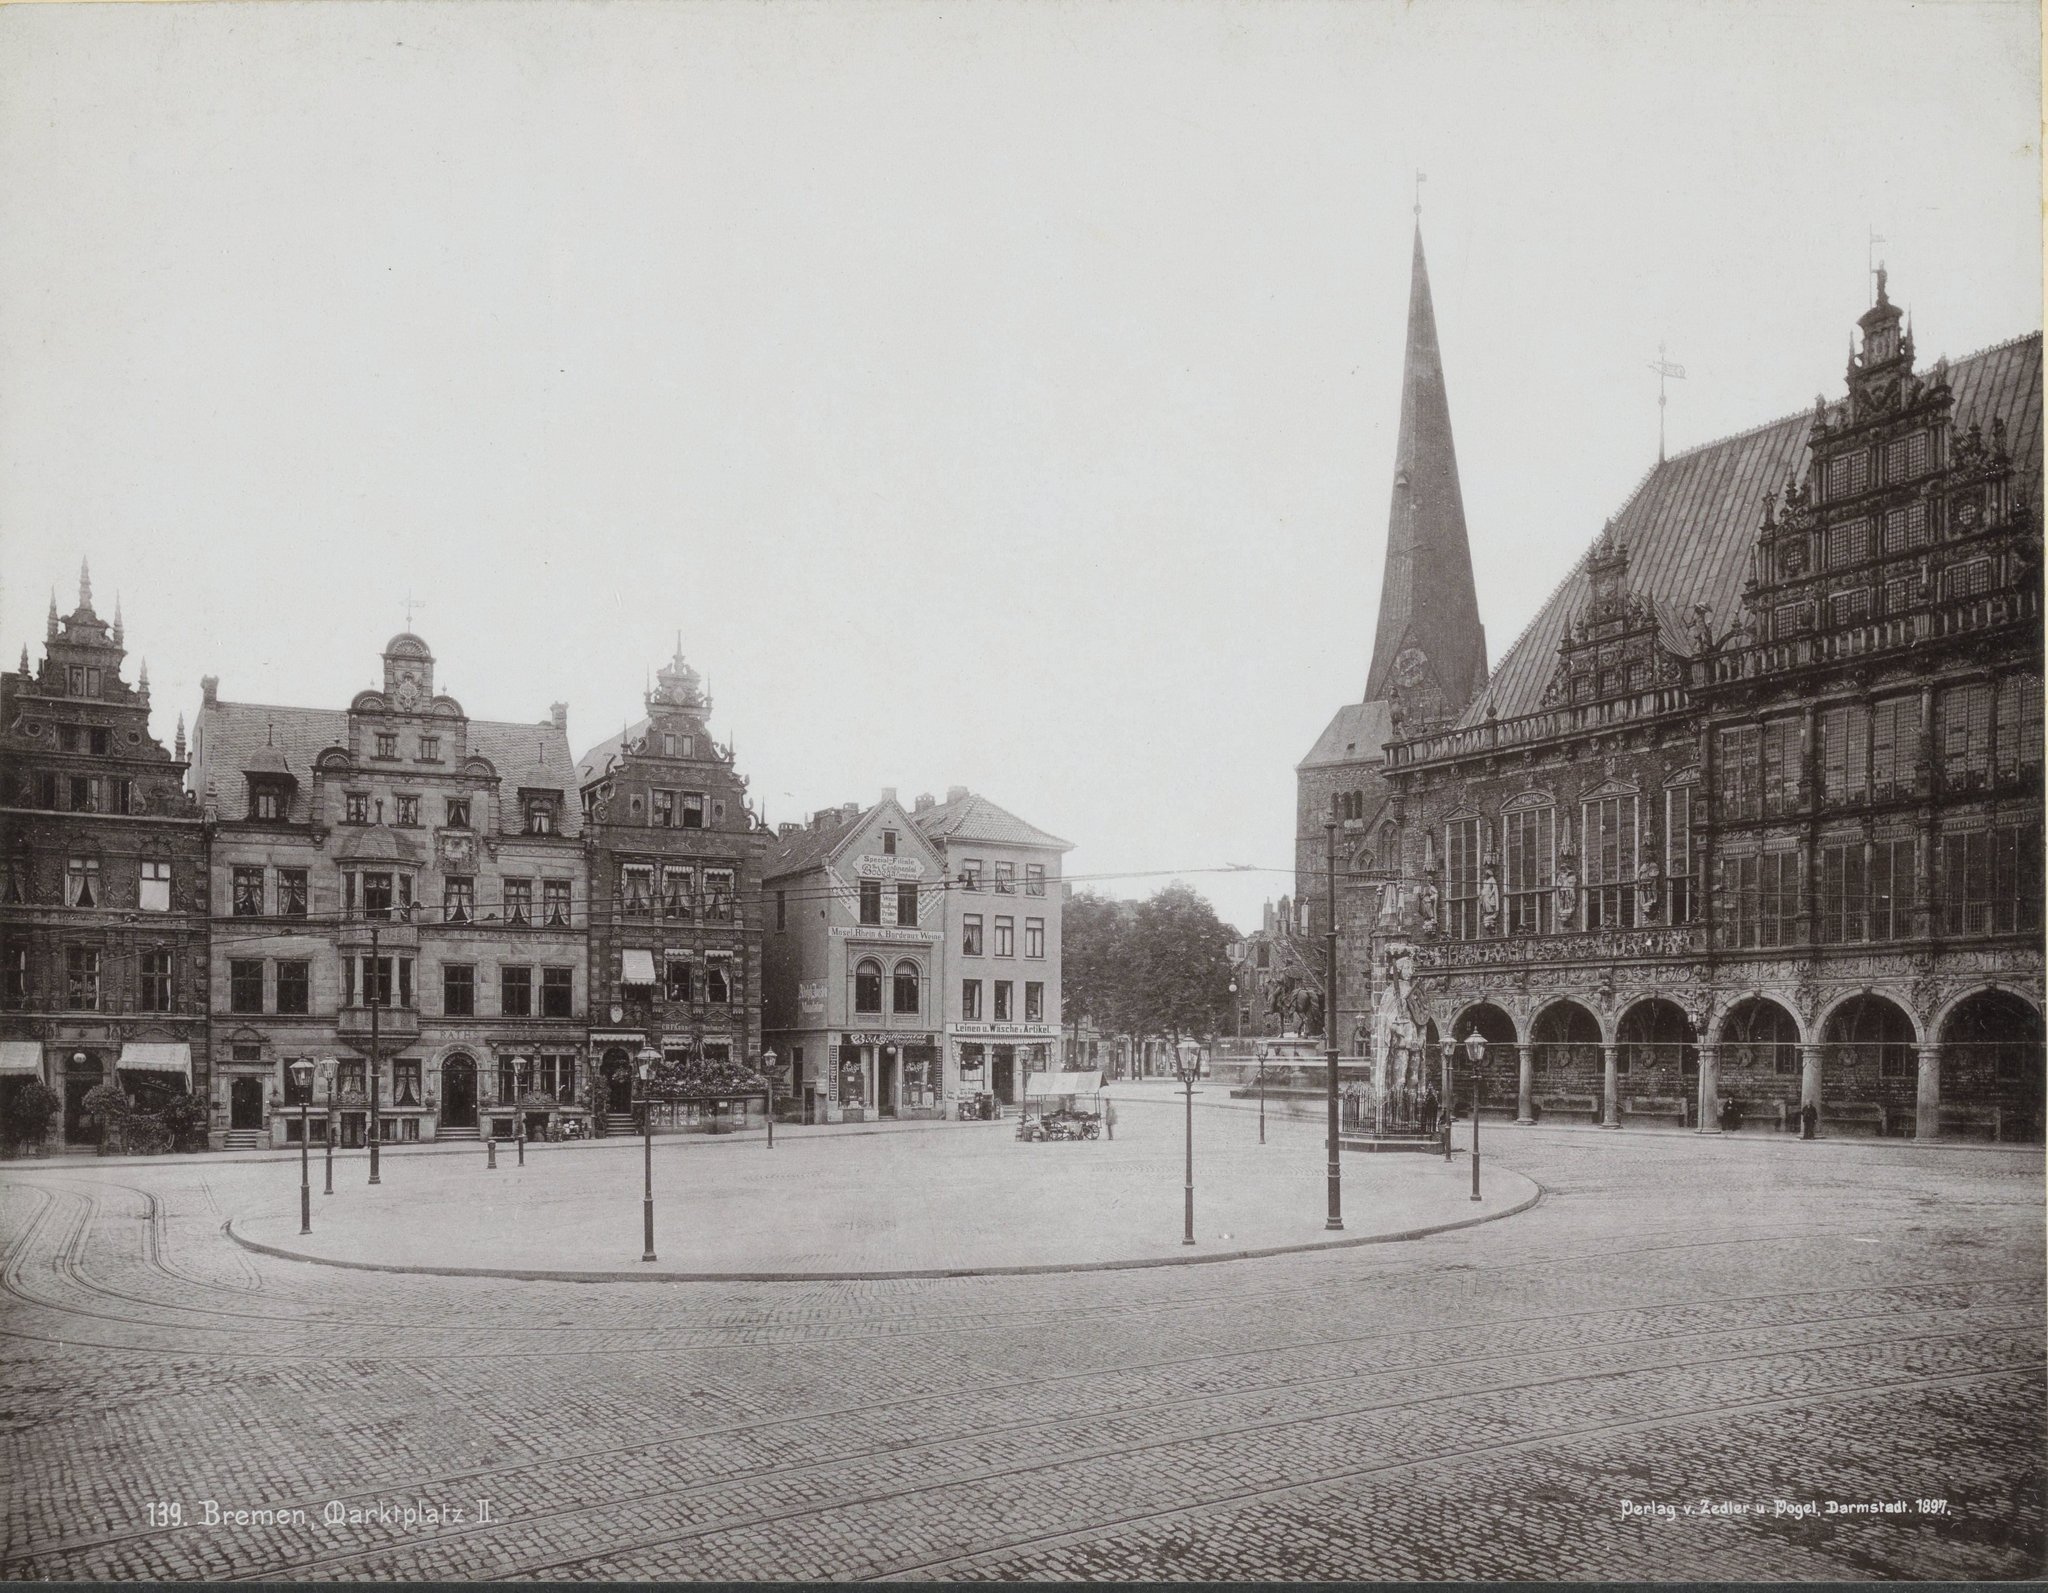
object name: photomechanical print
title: Marktplatz in Bremen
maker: Anonymous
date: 1897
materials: cardboard, paper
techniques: photograph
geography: bremen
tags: square, place, circus, etc.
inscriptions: title: ‘139. Bremen, Marktplatz II.’, inscription: ‘Verlag v. Zedler u. Vogel, Darmstadt. 1897.’